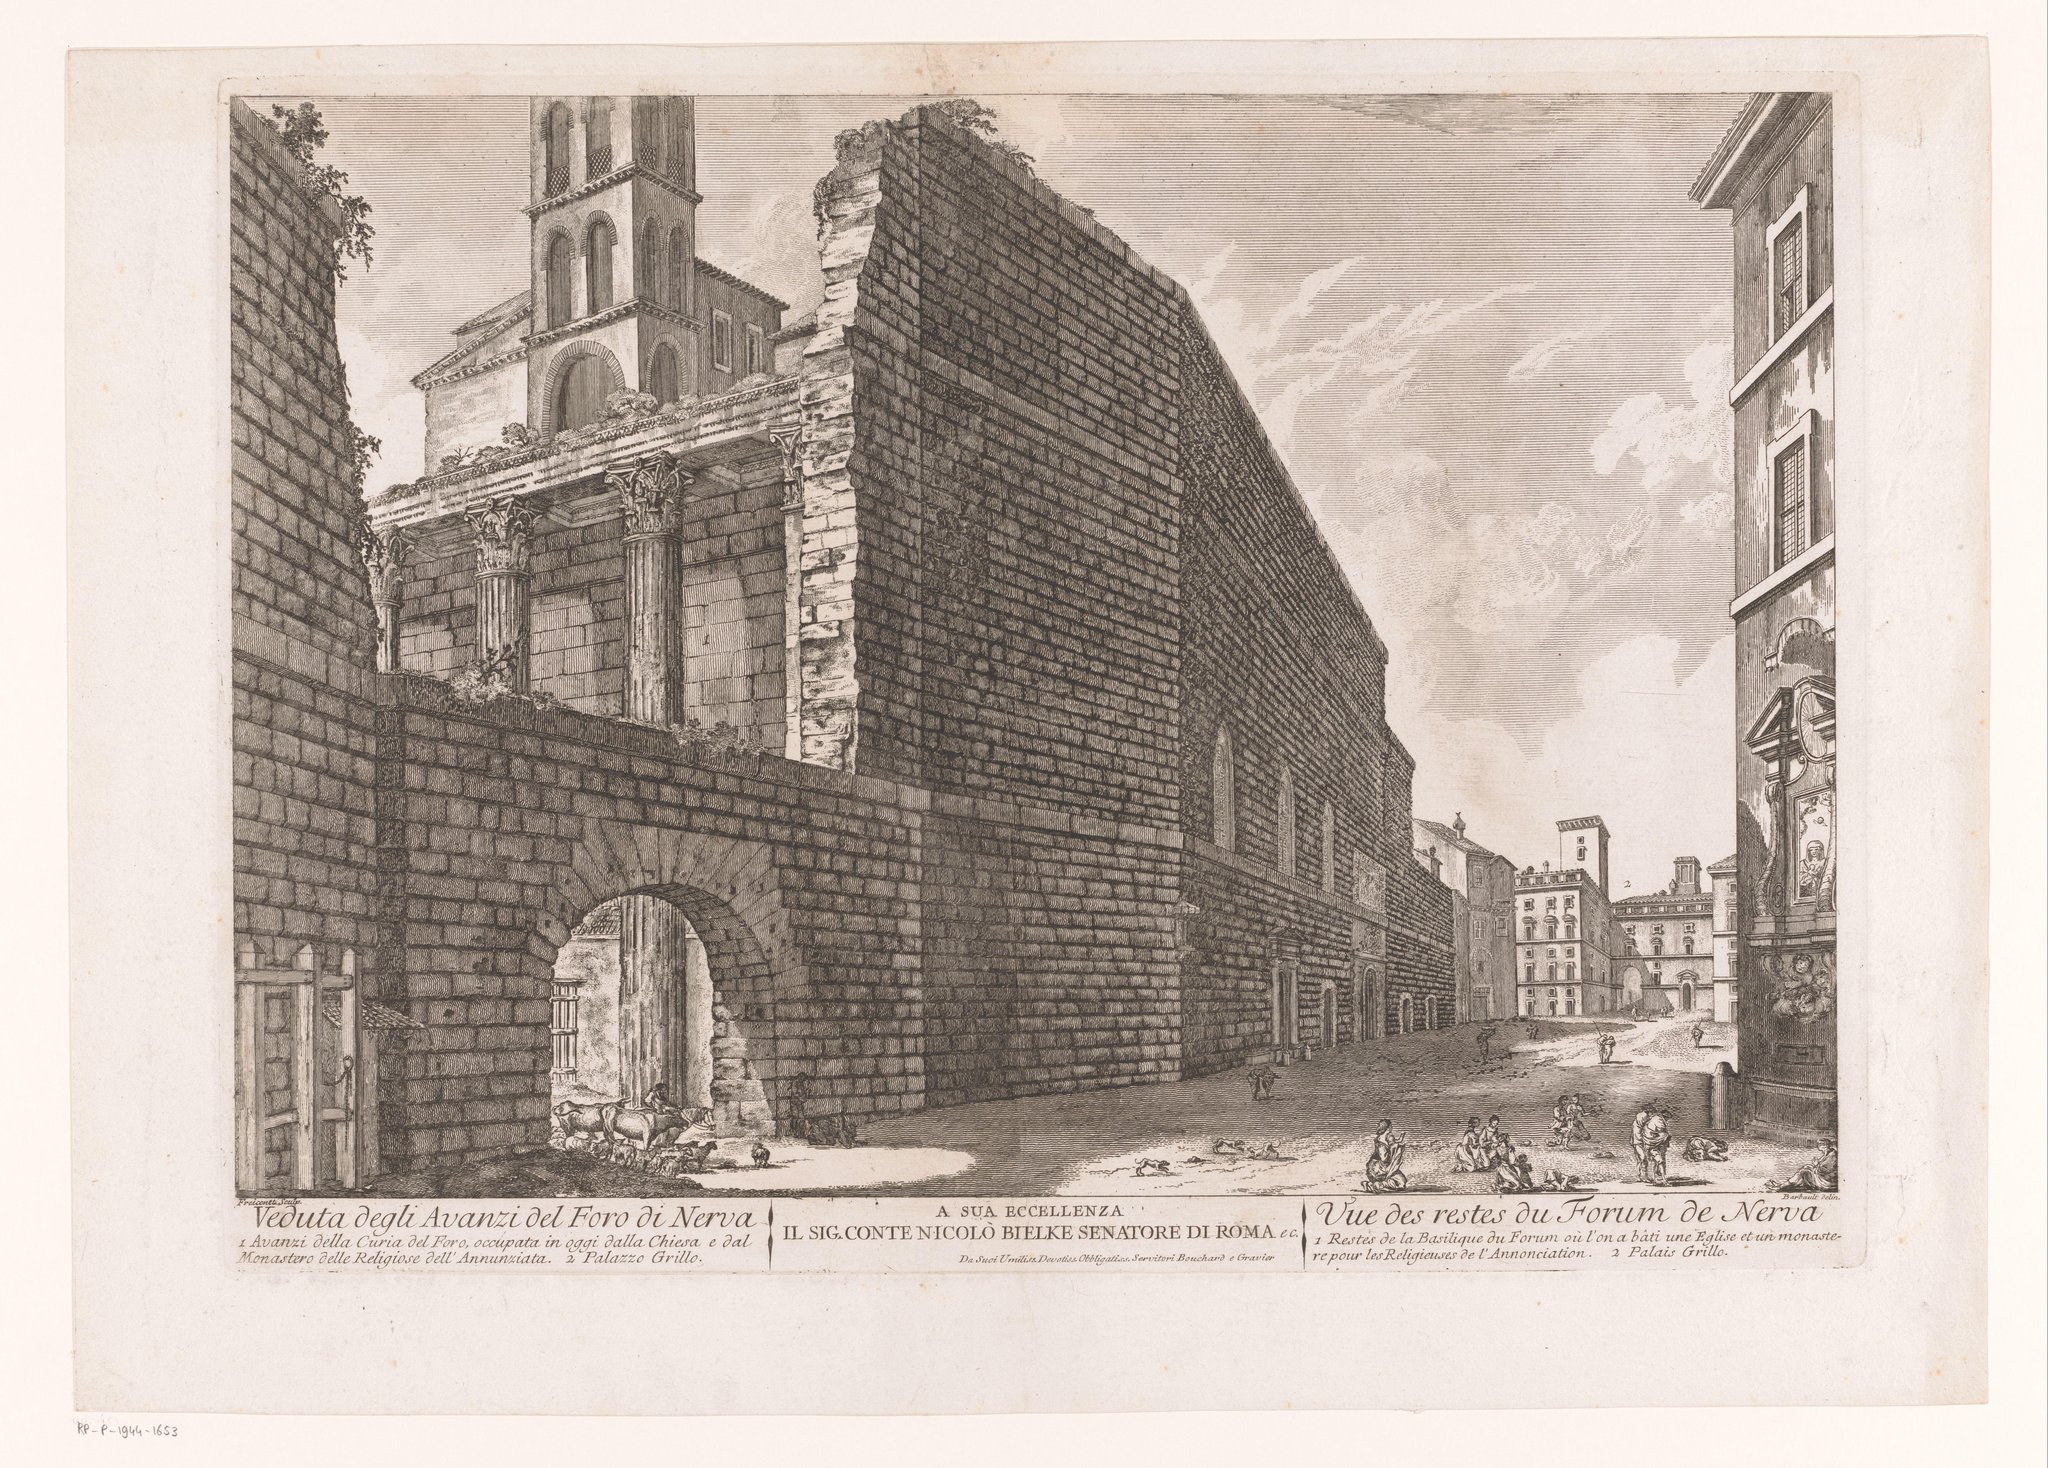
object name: book illustration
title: Vue des restes du Forum de Nerva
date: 1763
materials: paper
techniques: etching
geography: rome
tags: city-view in general; 'veduta', ruin of a building ~ architecture, church (exterior)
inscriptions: collector's mark: Lugt 2228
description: Prent waarschijnlijk gebruikt voor: Barbault, Jean. Les plus beaux édifices de Rome moderne publiés par Jean Barbault peintre (...). Rome: Bouchard et Gravier, 1763.